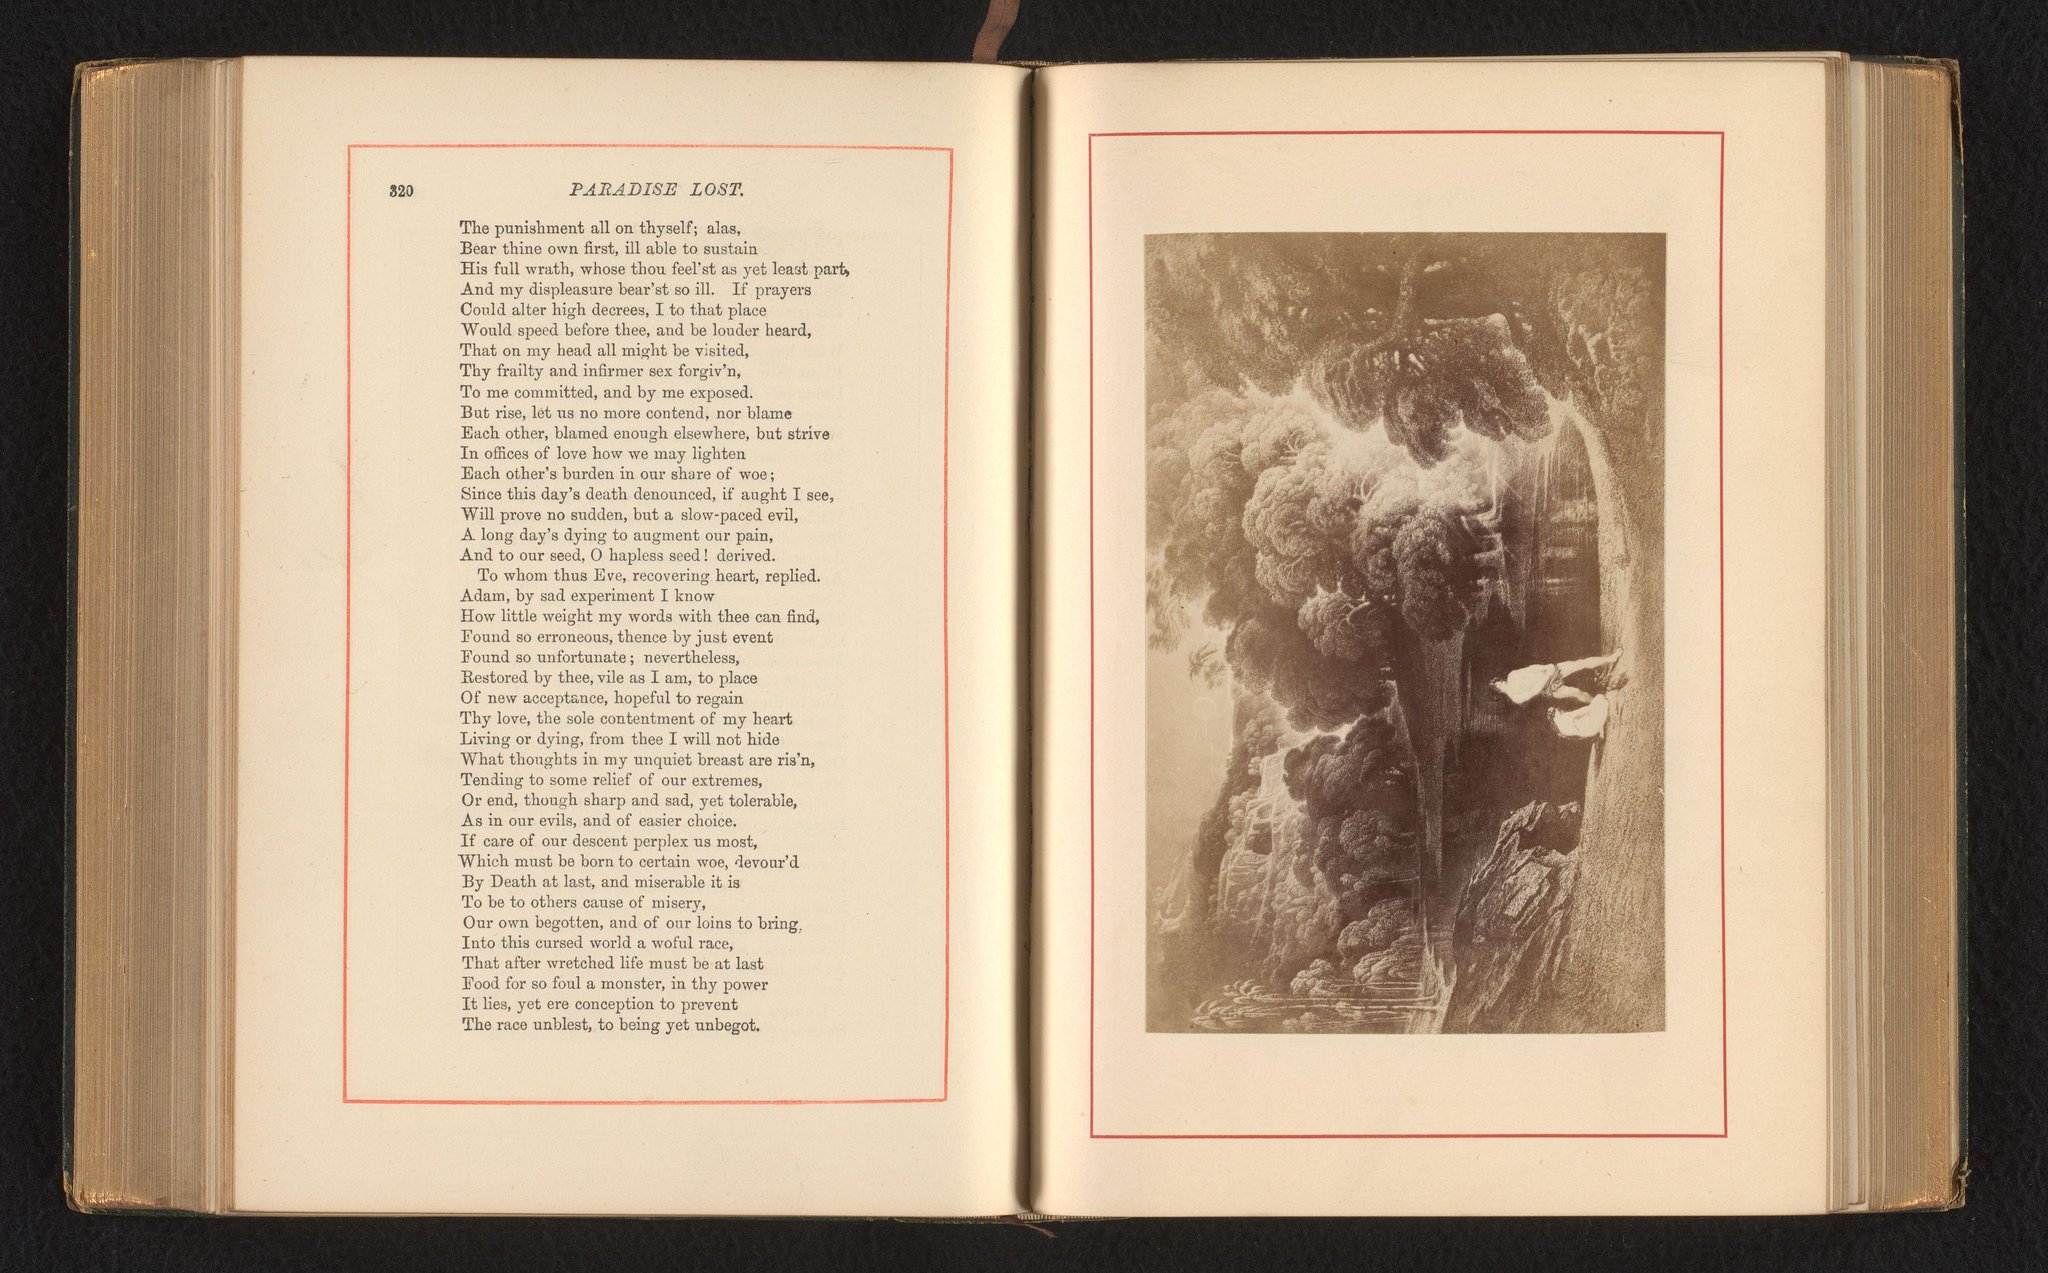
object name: page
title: Fotoreproductie van een schilderij van Adam en Eva uit het paradijs verdreven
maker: Anonymous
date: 1866-1890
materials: paper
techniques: albumen print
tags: expulsion of adam and eve from paradise (genesis 3:22-24), picture, painting